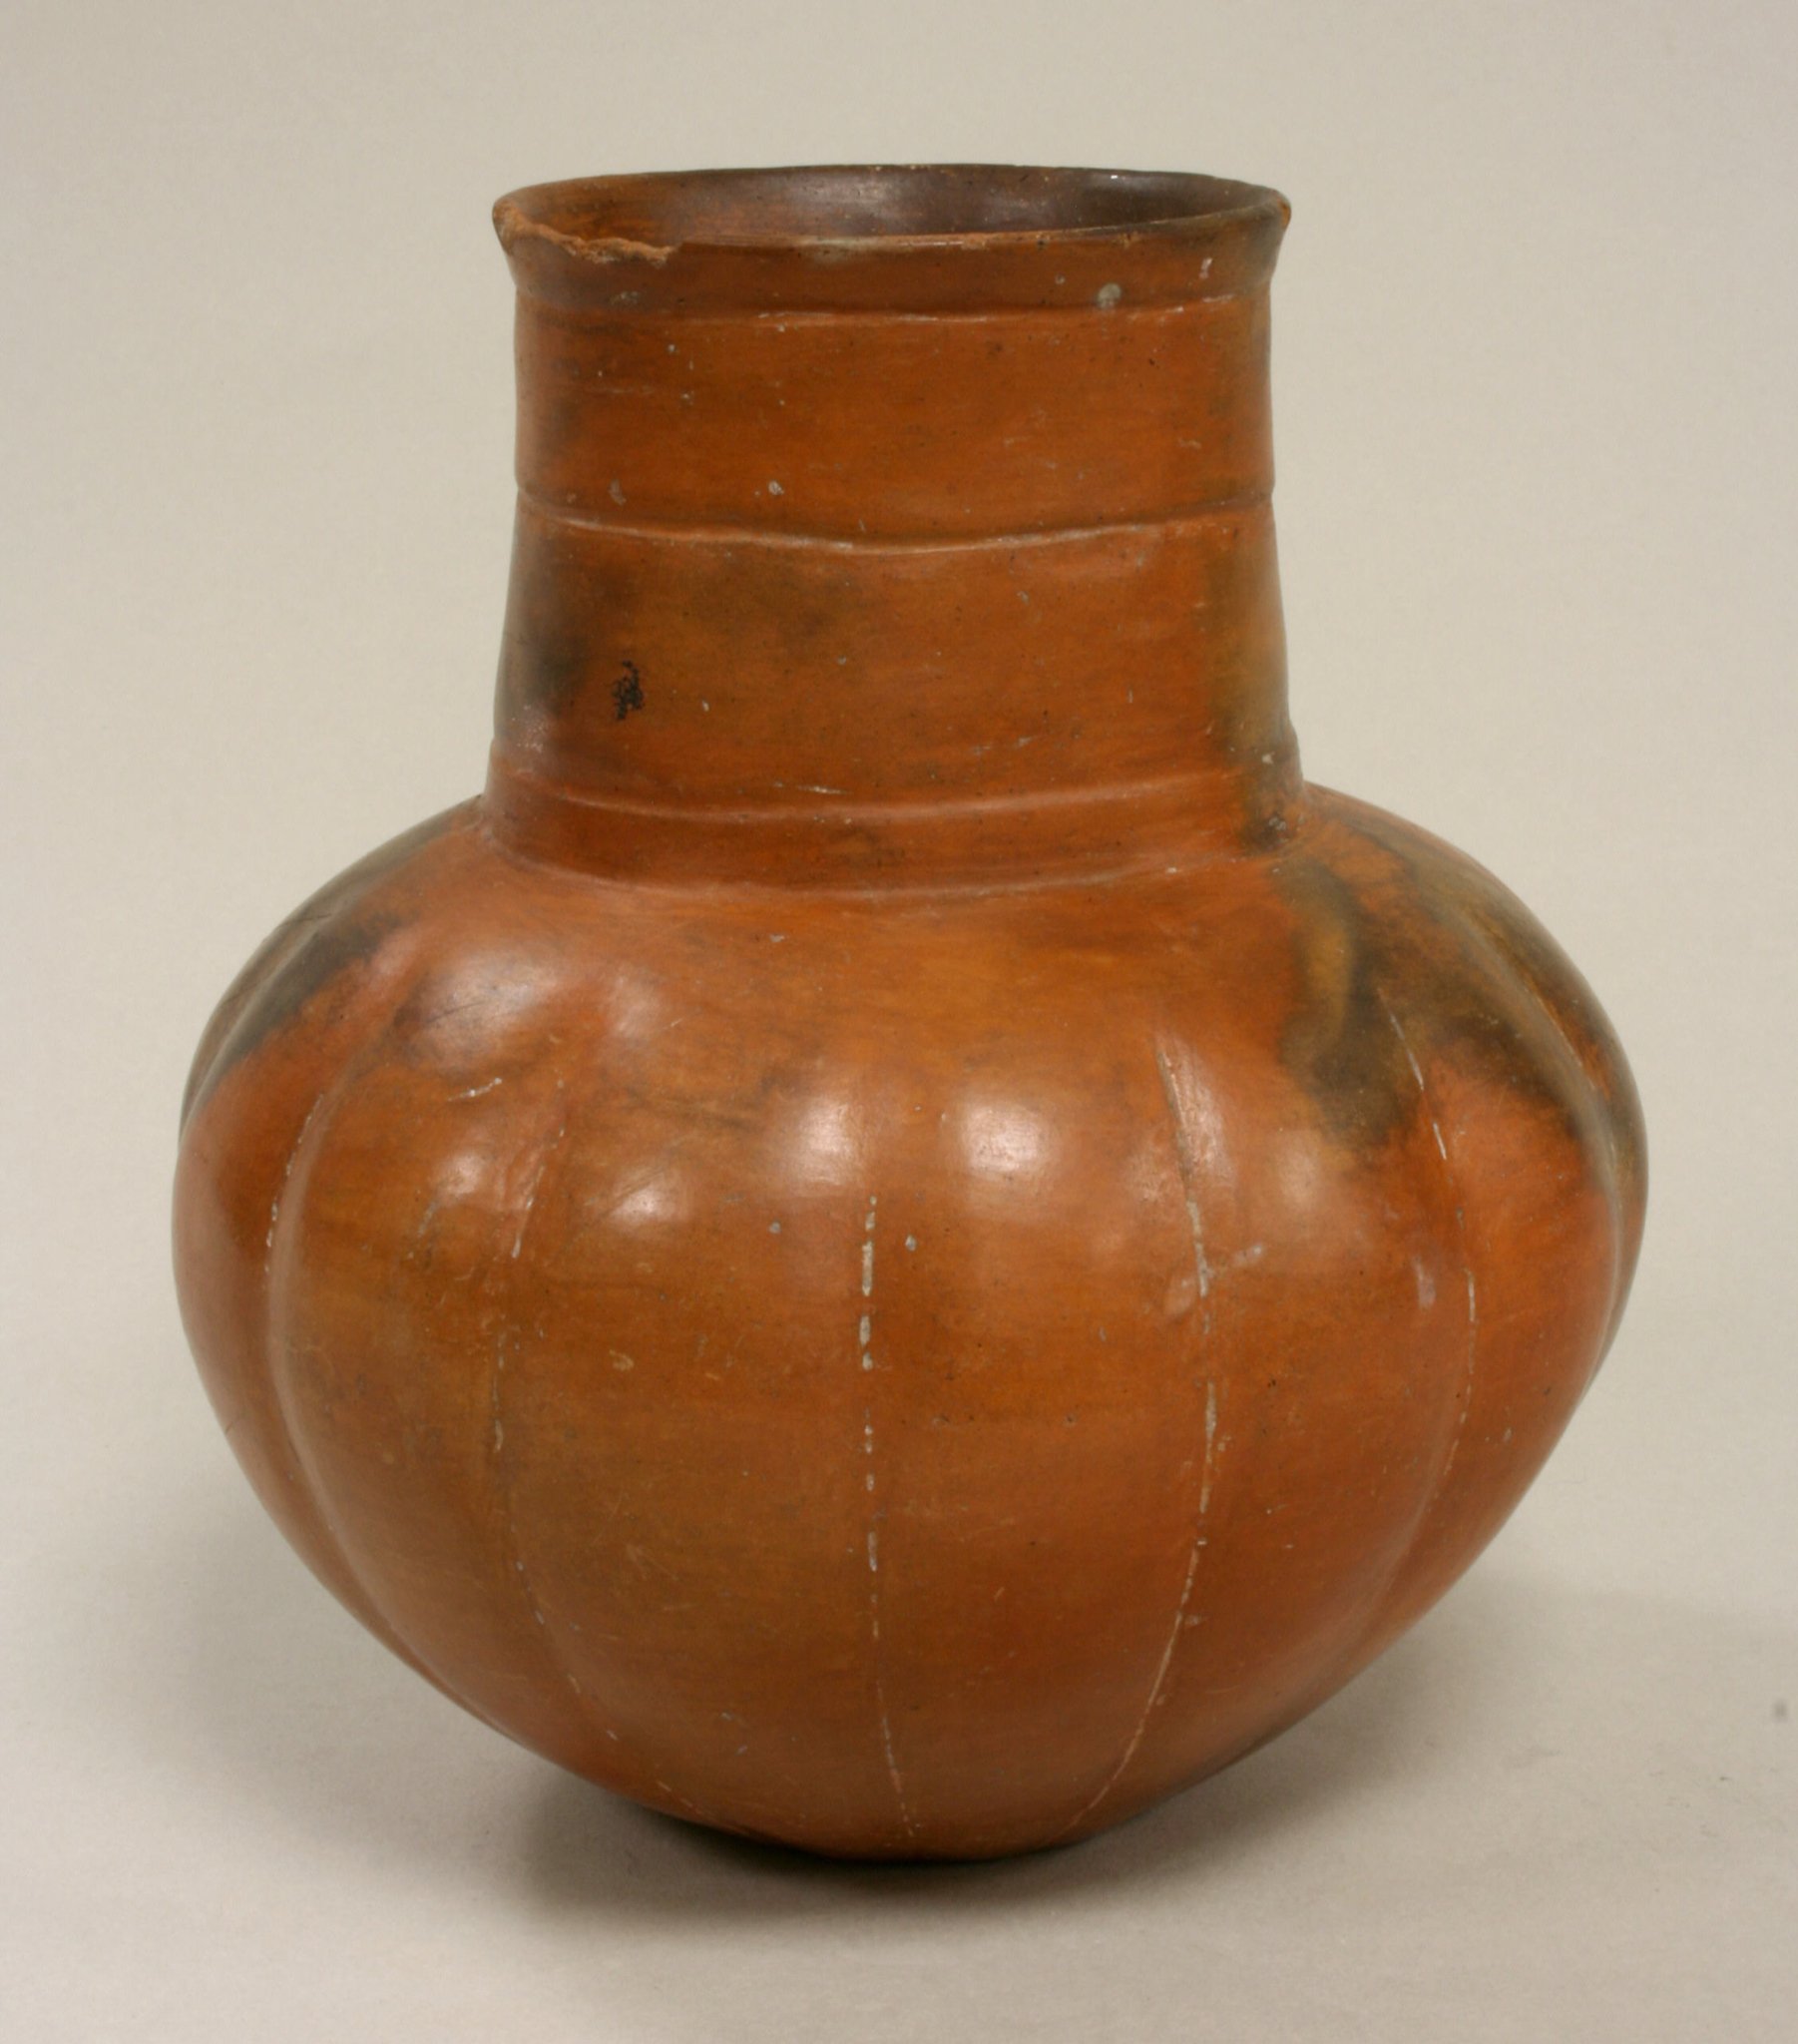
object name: jar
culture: mexican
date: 901-1500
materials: ceramic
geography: mexico